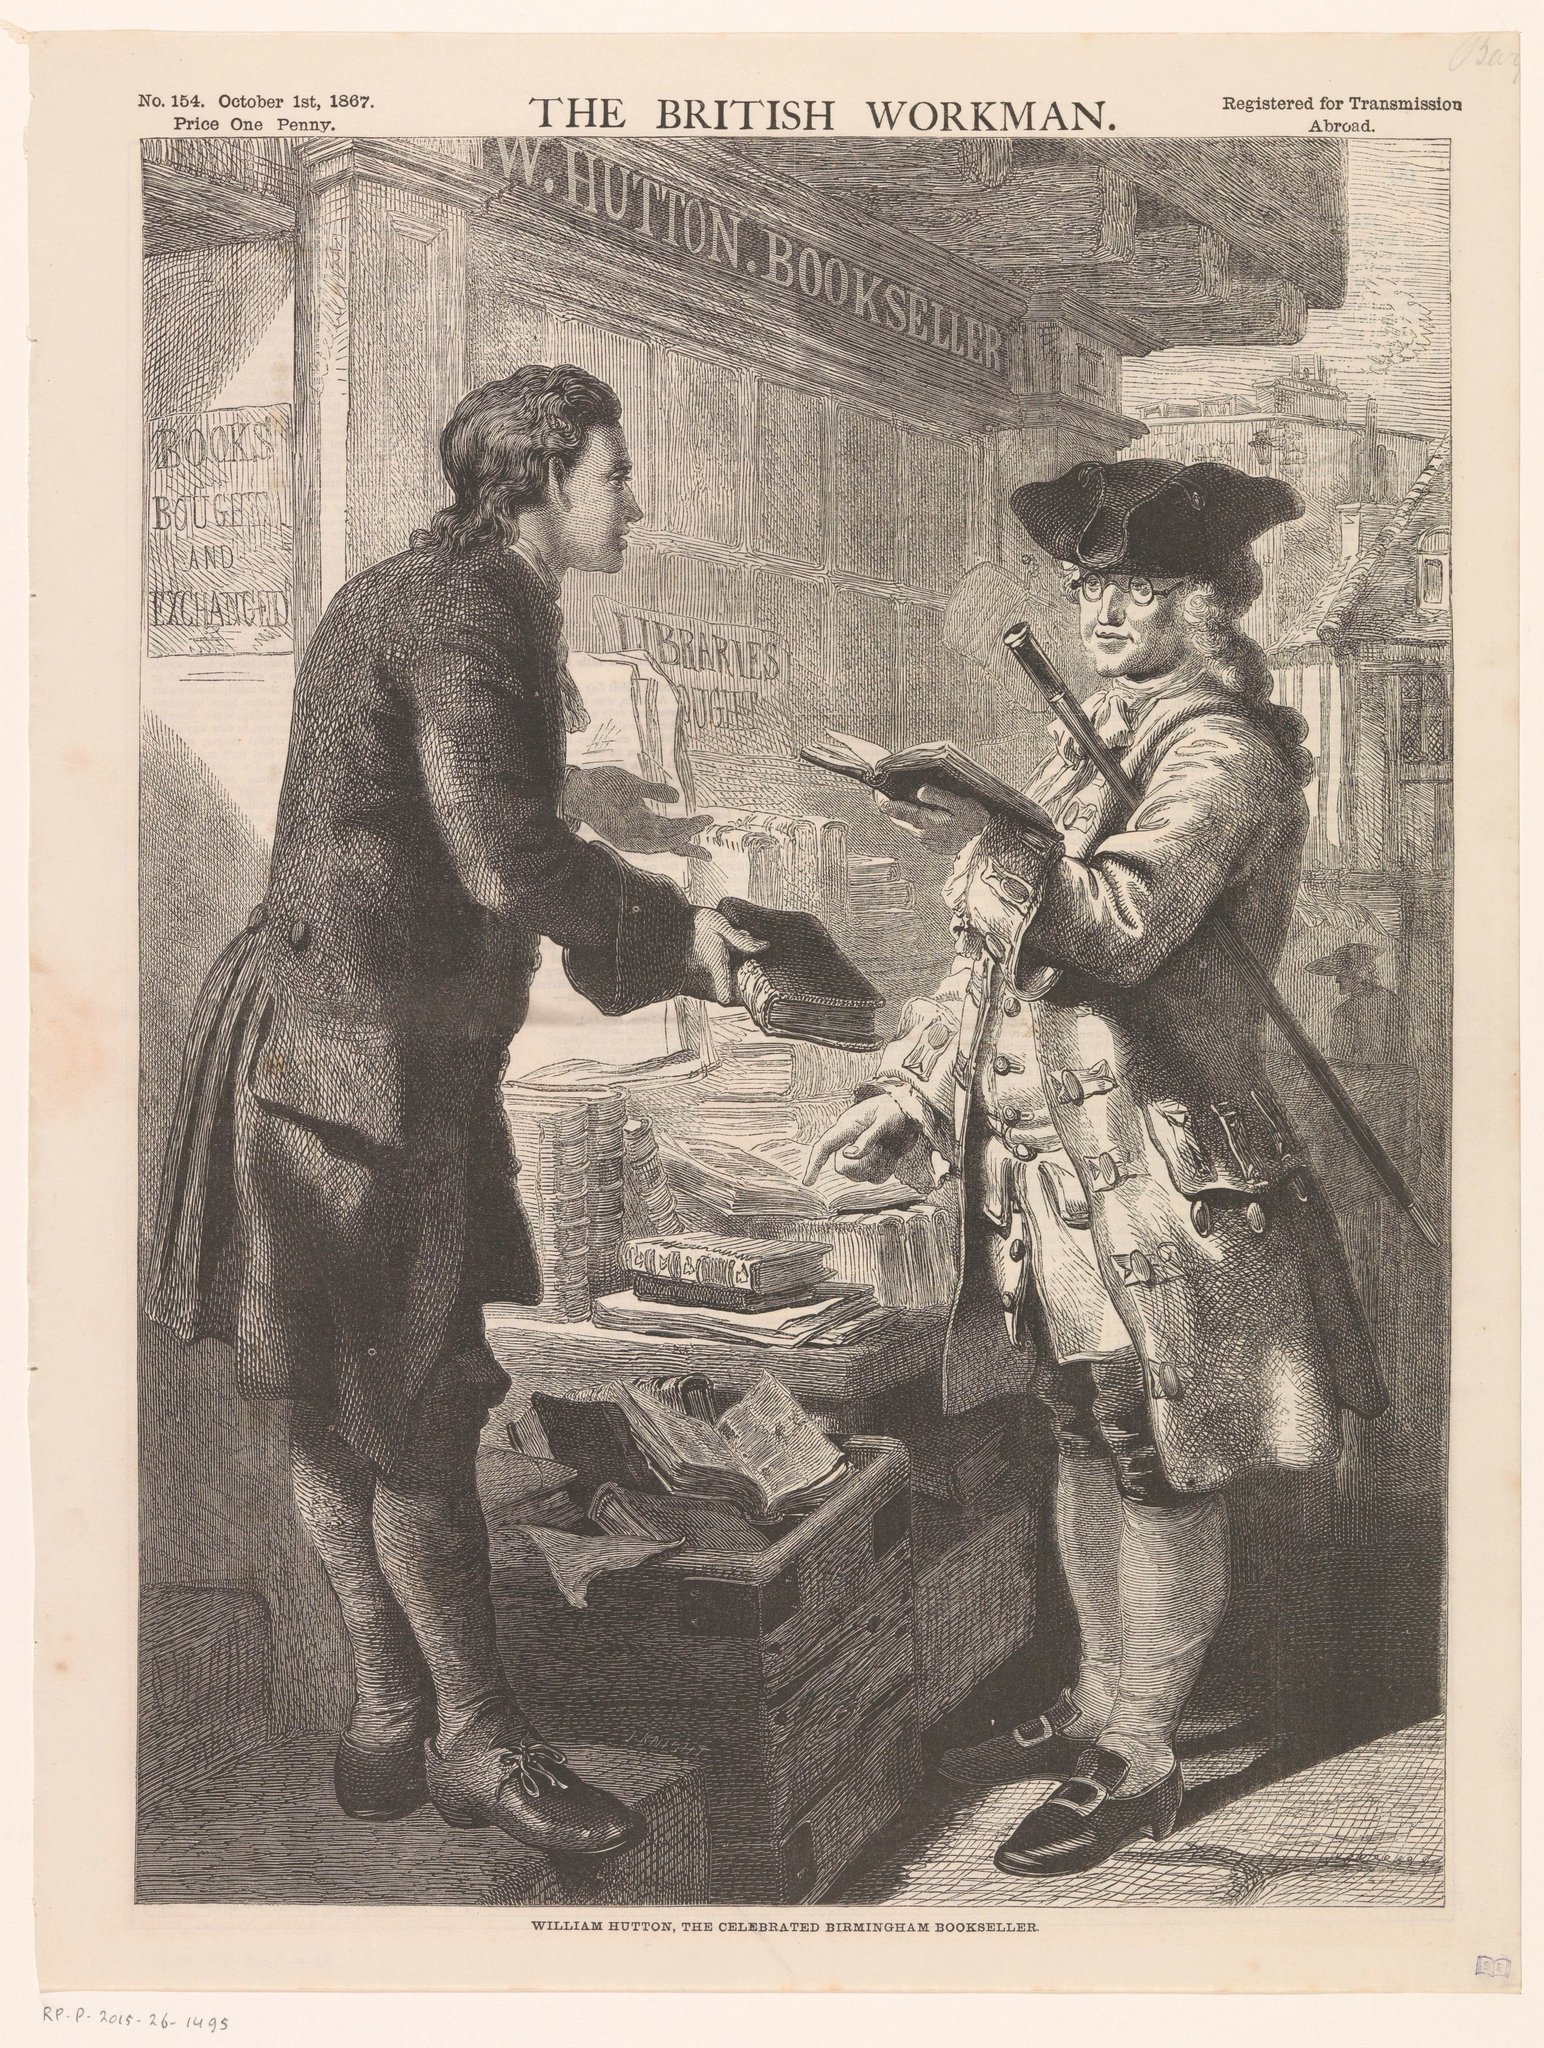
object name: print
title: Portret van boekverkoper William Hutton, in gesprek met een klant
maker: Anonymous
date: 1810-1867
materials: paper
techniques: engraving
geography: london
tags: birmingham, book-shop, bookseller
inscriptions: collector's mark: Lugt 4780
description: De klant is gekleed in een lange jas en heeft een driehoekige steek op zijn hoofd; onder zijn arm houdt hij een wandelstok. Hij bekijkt de boeken die William Hutton heeft uitgestald voor zijn winkel in Birmingham. Met een levensbeschrijving van William Hutton op verso.